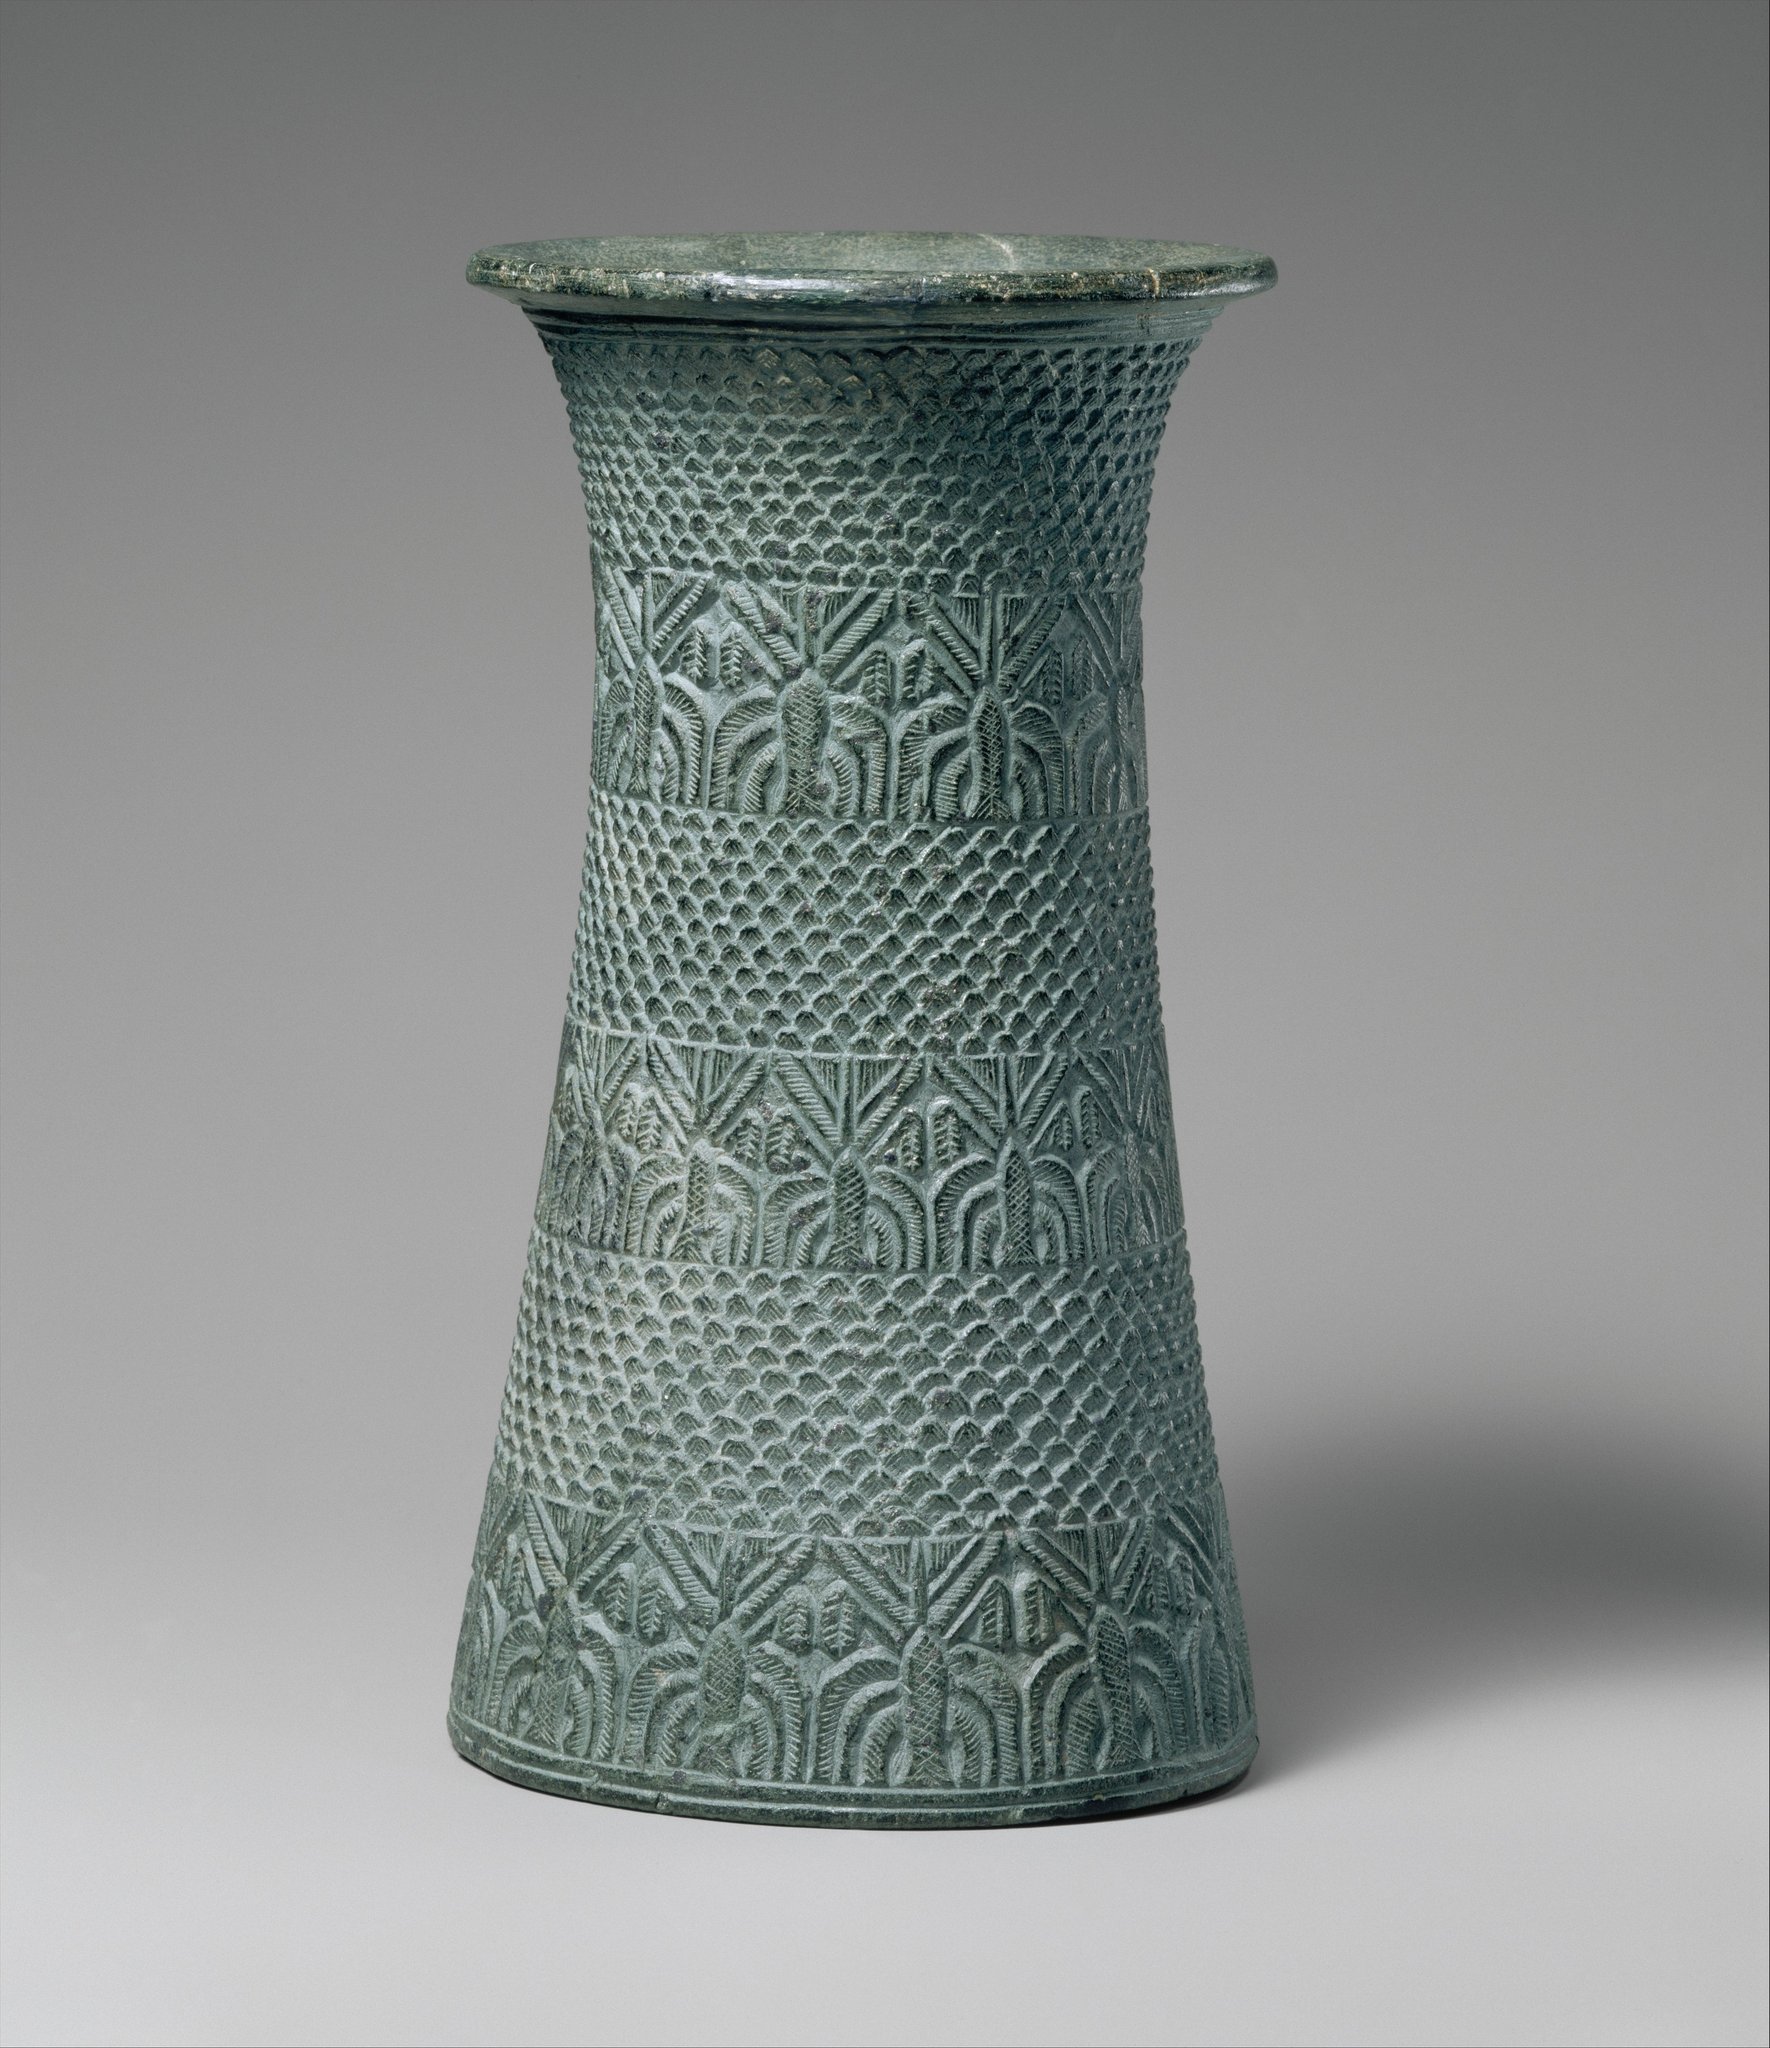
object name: vase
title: Vase with overlapping pattern and three bands of palm trees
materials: mineral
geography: persian gulf region or southern iran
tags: palms